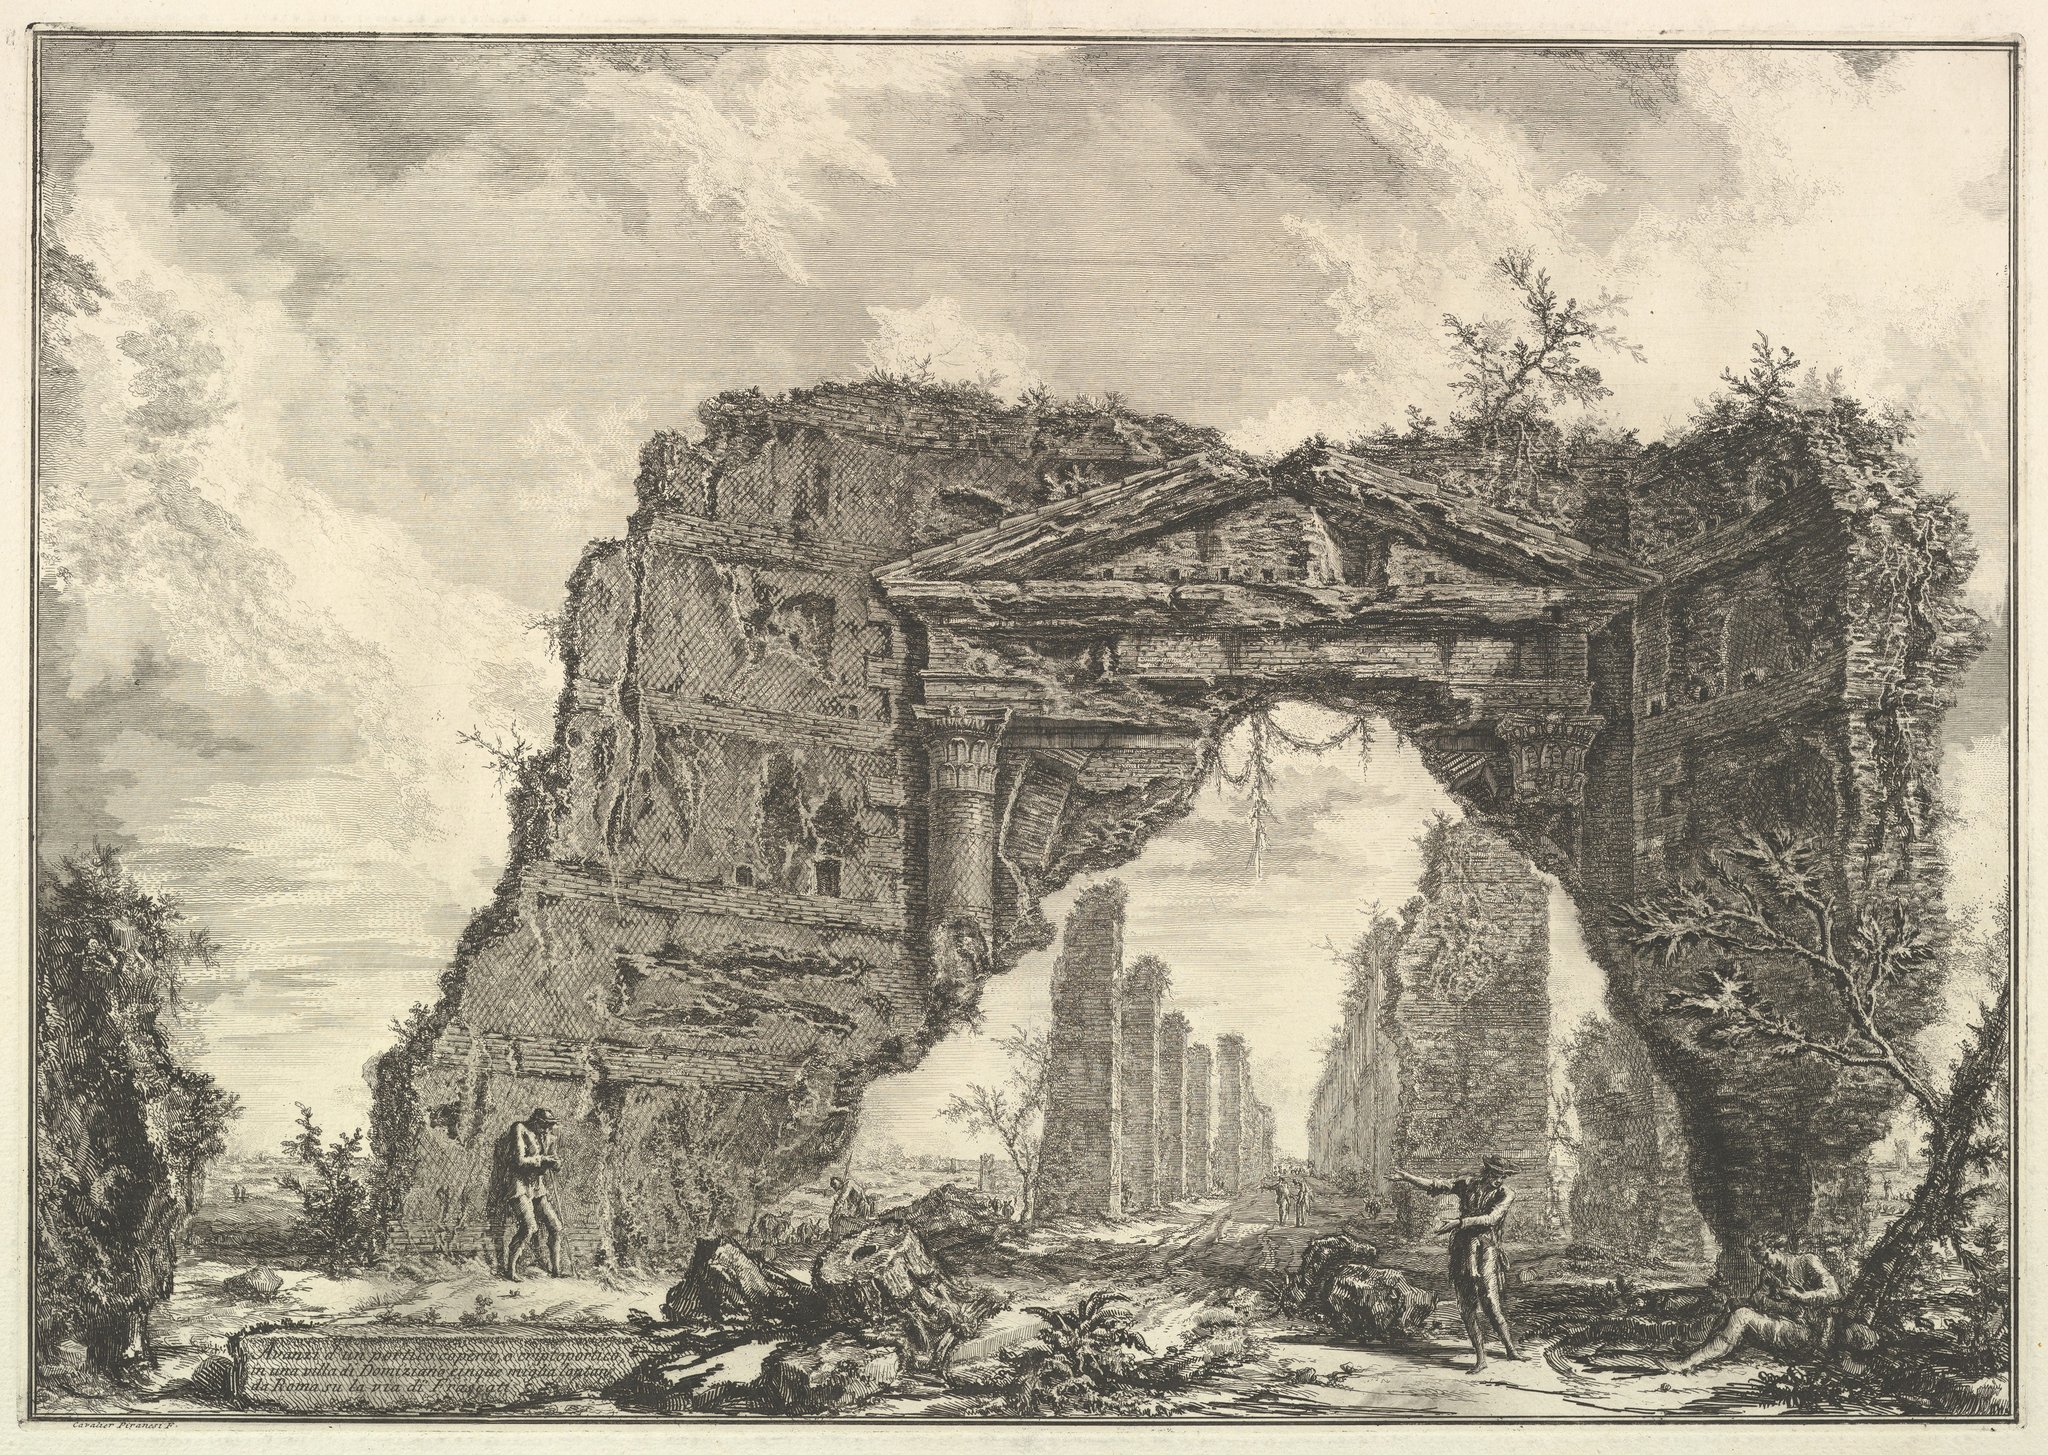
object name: print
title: Remains of a covered portico, or a cryptoporticus, in a villa of Domitian, five miles outside Rome on the Frascati road, from Vedute di Roma (Roman Views)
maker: giovanni battista piranesi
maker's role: artist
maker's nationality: italian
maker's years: 1720-1778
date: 1766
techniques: etching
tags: ruins,rome